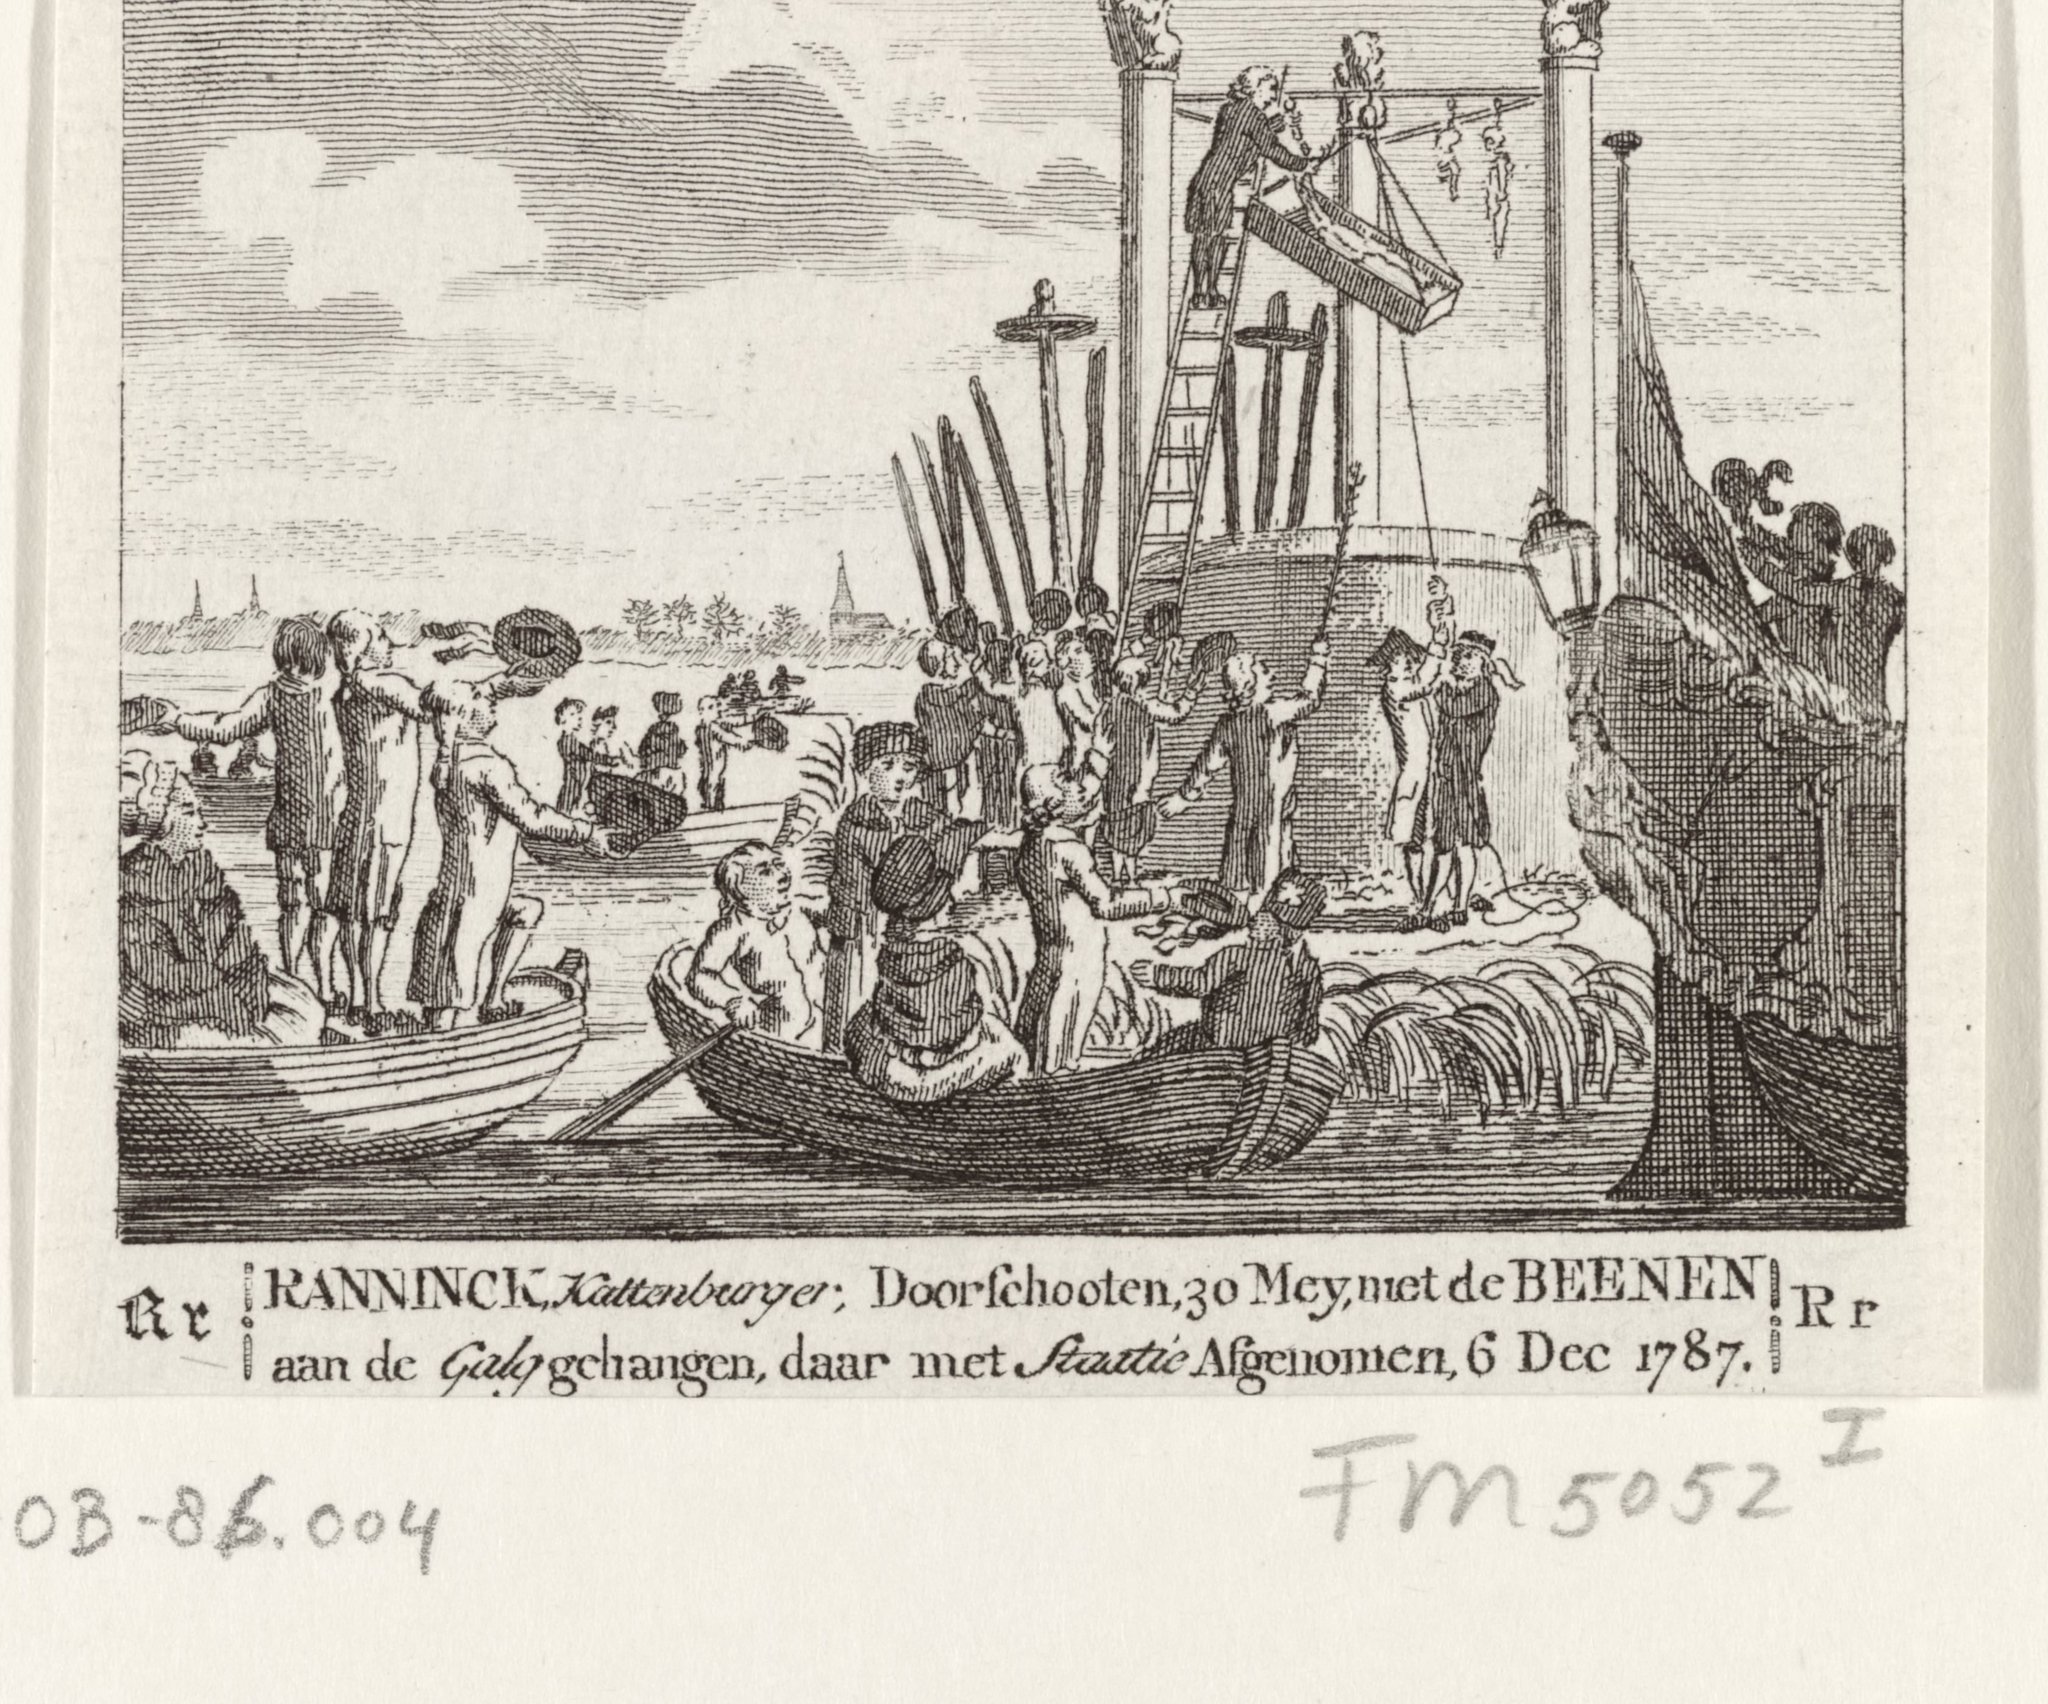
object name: print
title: Lijk van Johannes Rannink van de galg gehaald, 1787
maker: Anonymous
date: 1787-1790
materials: paper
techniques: etching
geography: northern netherlands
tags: re-burial, the corpse, body of the executed displayed in public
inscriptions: collector's mark: Lugt 2228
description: Het lijk van Johannes Rannink, aanvoerder van de bijltjes, de opstandige Oranjegezinde Amsterdamse scheepstimmerlieden die op het eiland Kattenburg in opstand kwamen tegen het patriotse stadsbestuur, en die sneuvelde op 30 mei 1787, wordt op 6 december met statie van de galg gehaald. Plaatje behorend bij de letter R uit een ABC boek.